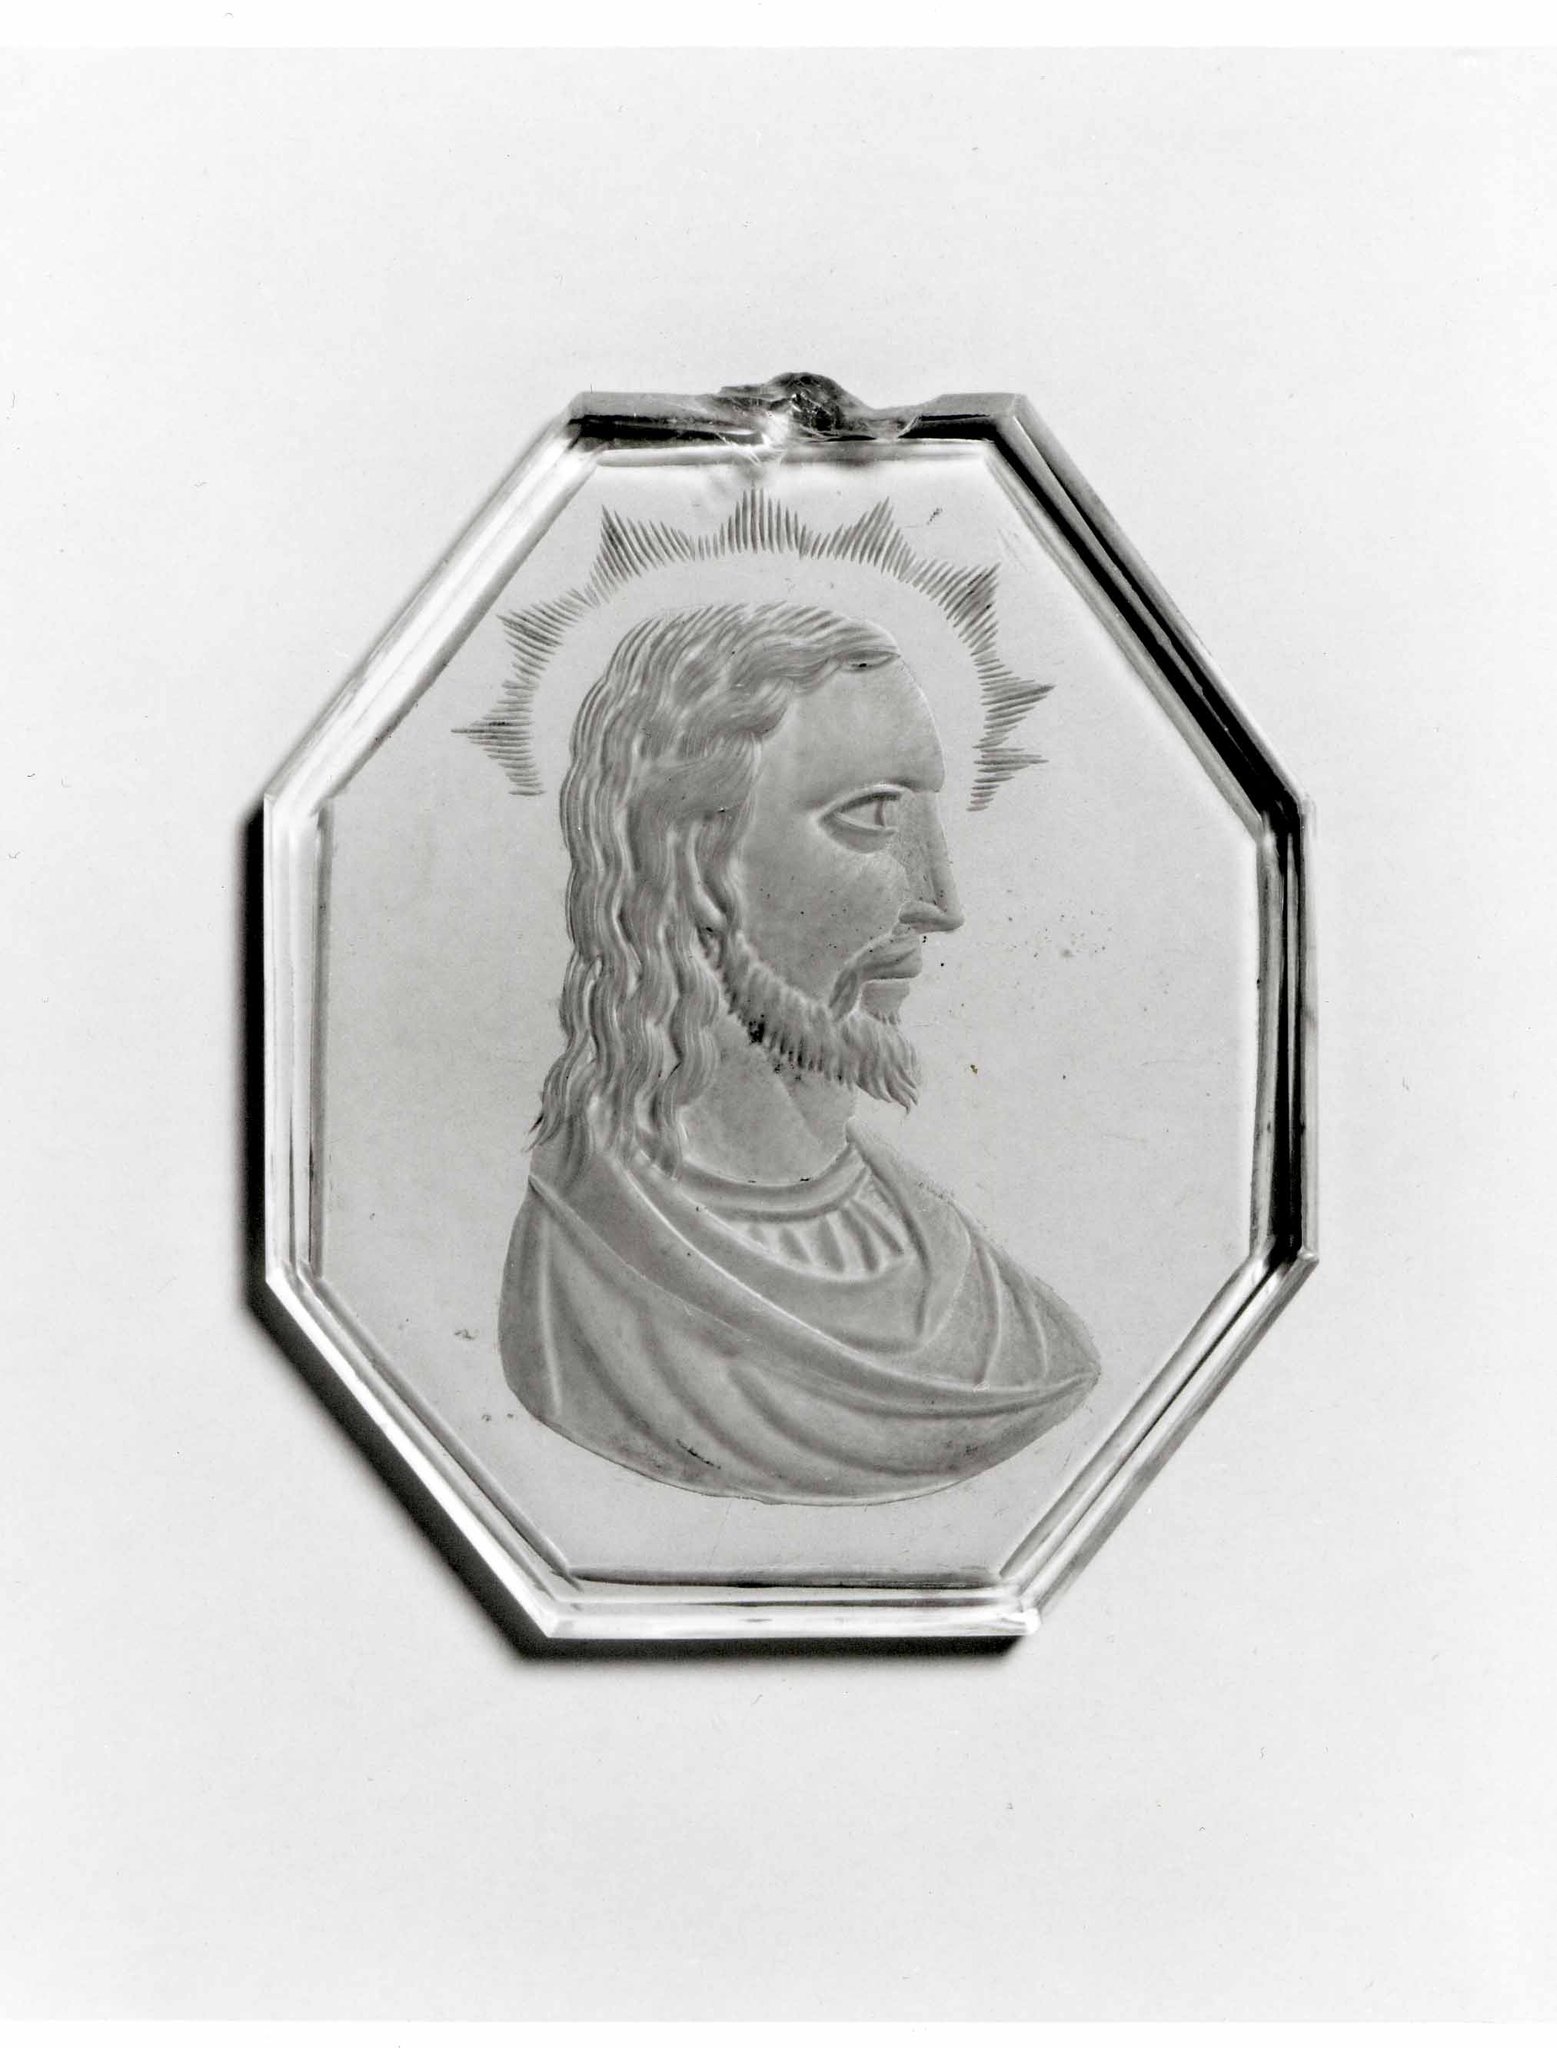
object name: pendant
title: Pendant with head of Christ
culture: italian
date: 1501-1600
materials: quartz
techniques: cutting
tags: christ